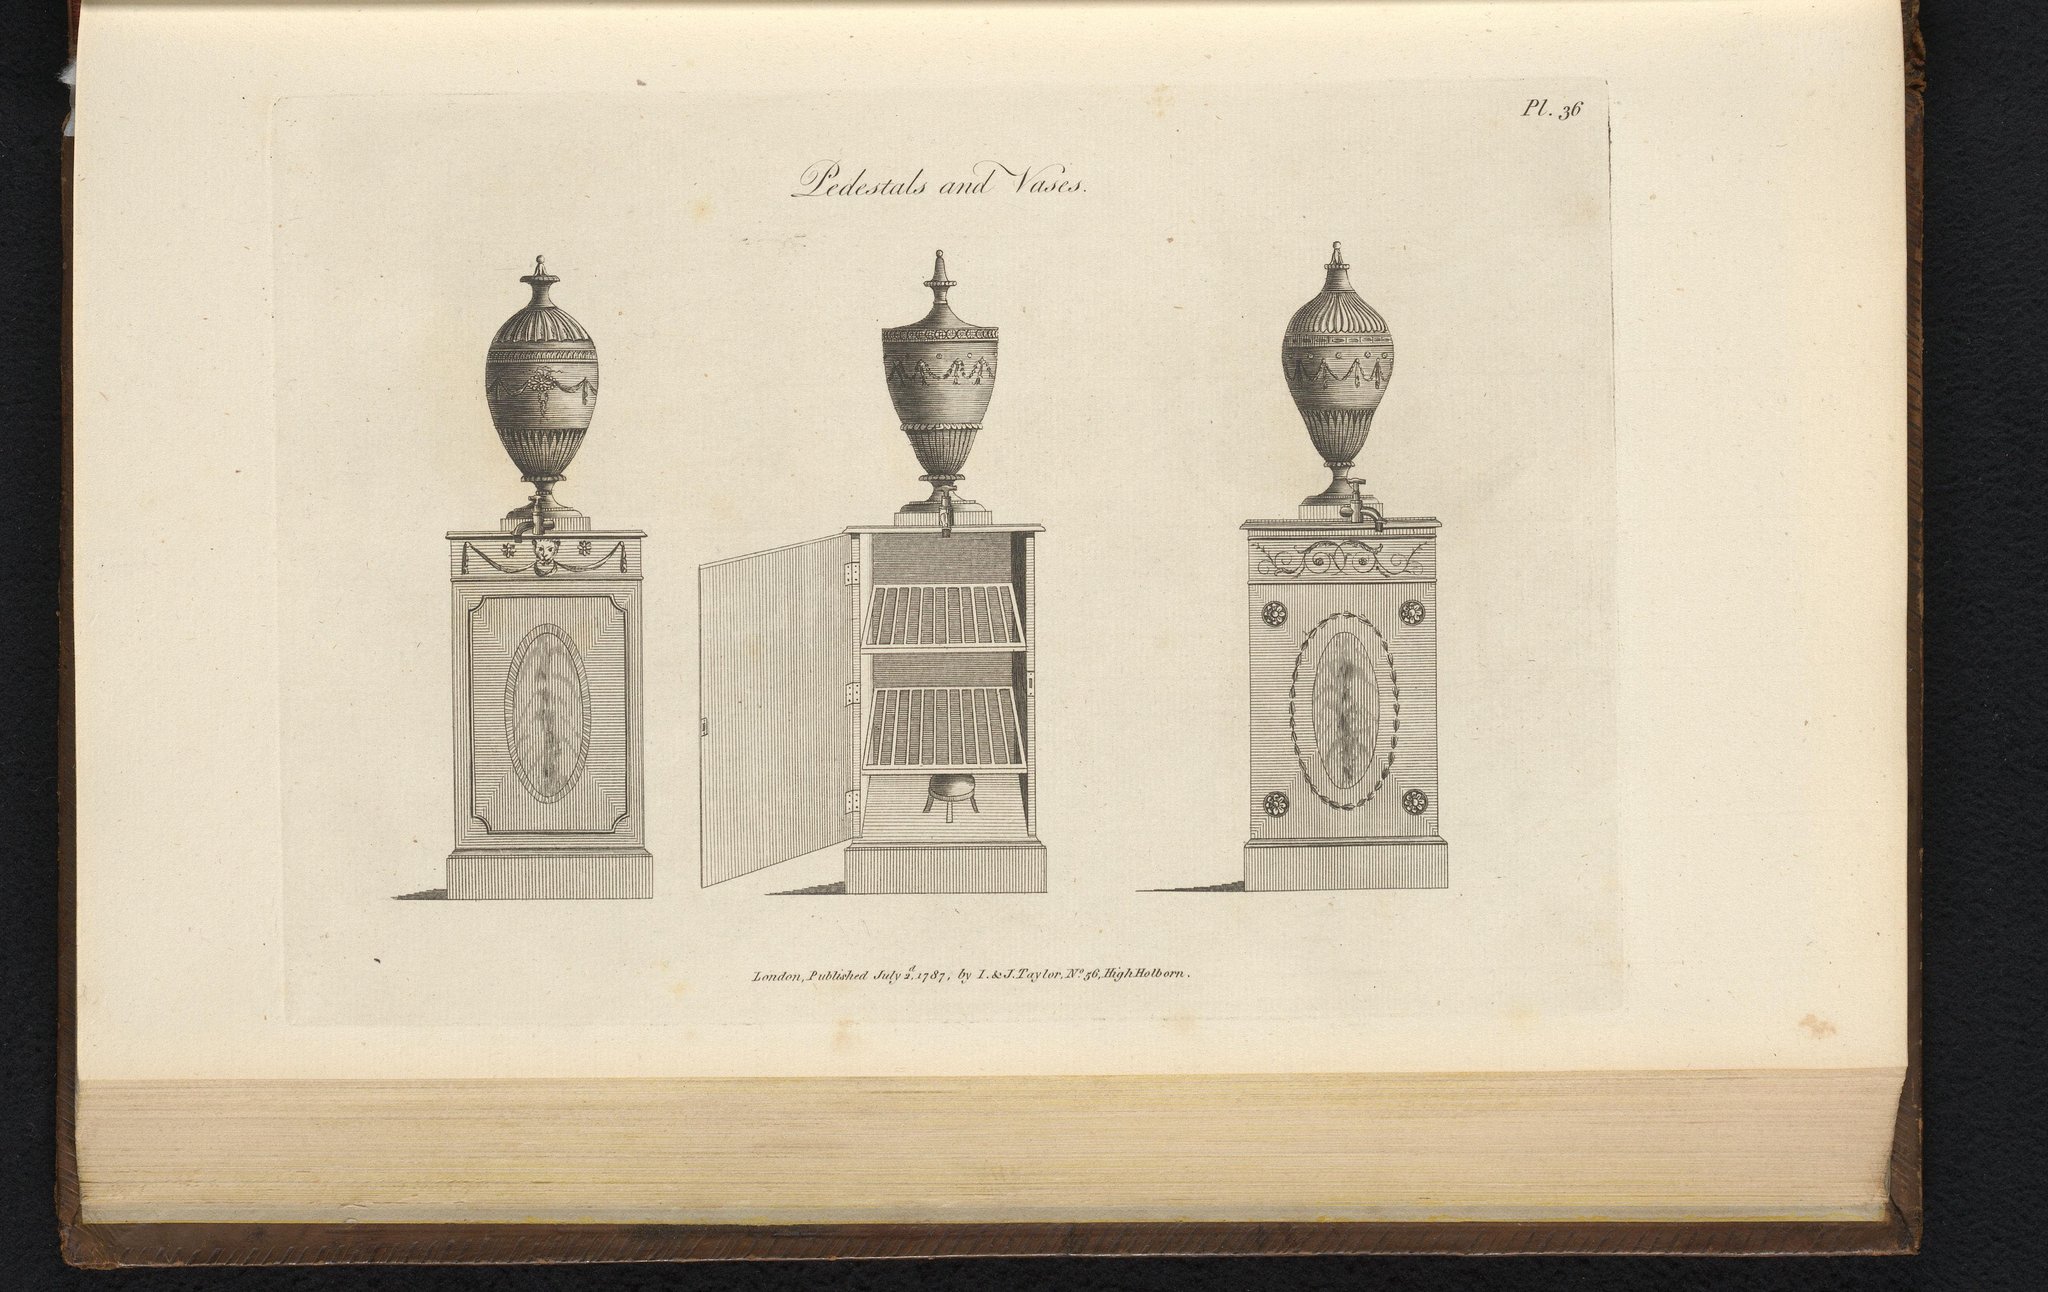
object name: print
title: Drie sokkels met vazen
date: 1787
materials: paper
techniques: engraving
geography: holborn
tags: pedestal of a piece of sculpture (perhaps in the form of a herm), container of stone: stone vase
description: Genummerd: Pl. 36. Prent maakt deel uit van een boek.